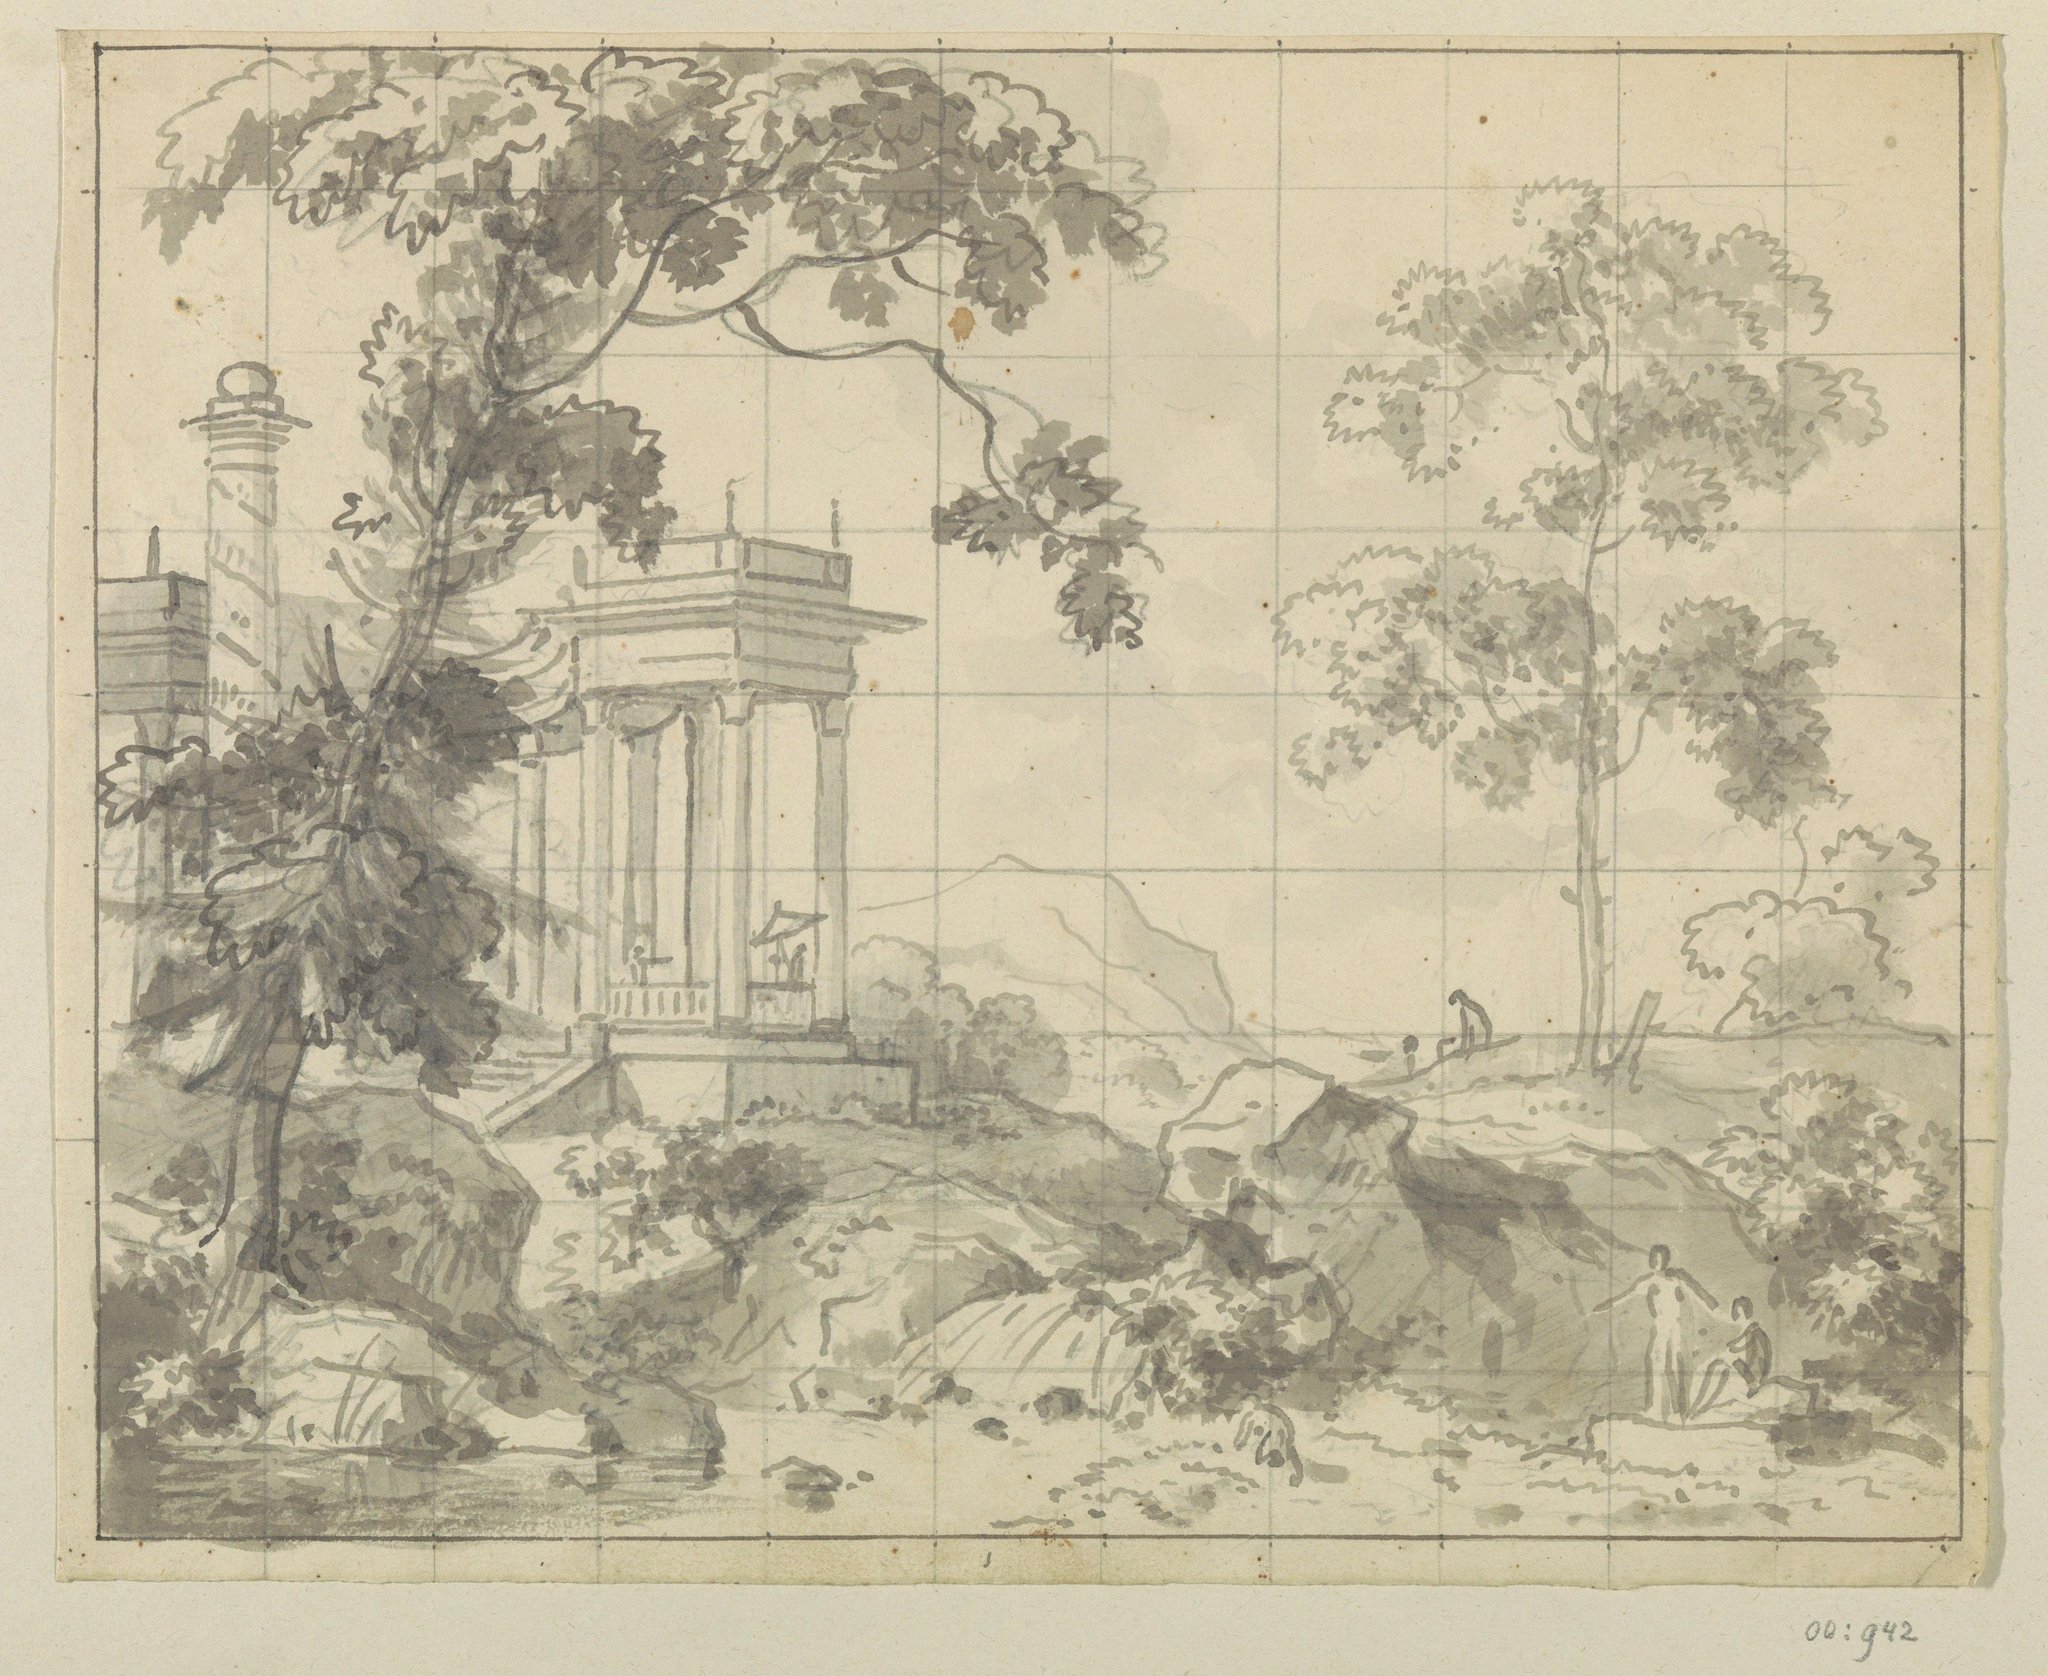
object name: album leaf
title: Arcadisch landschap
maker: jurriaan andriessen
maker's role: draughtsman, painter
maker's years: 1742-1819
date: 1760-1819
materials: paper, pencil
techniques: brush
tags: city-view in general; 'veduta', pastorals, arcadian scenes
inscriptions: inscription: ‘F. A. Hulshof’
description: Mogelijk ontwerptekening voor een kamerwand. Met op de achtergrond een raster. Tekening maakt deel uit van een album.